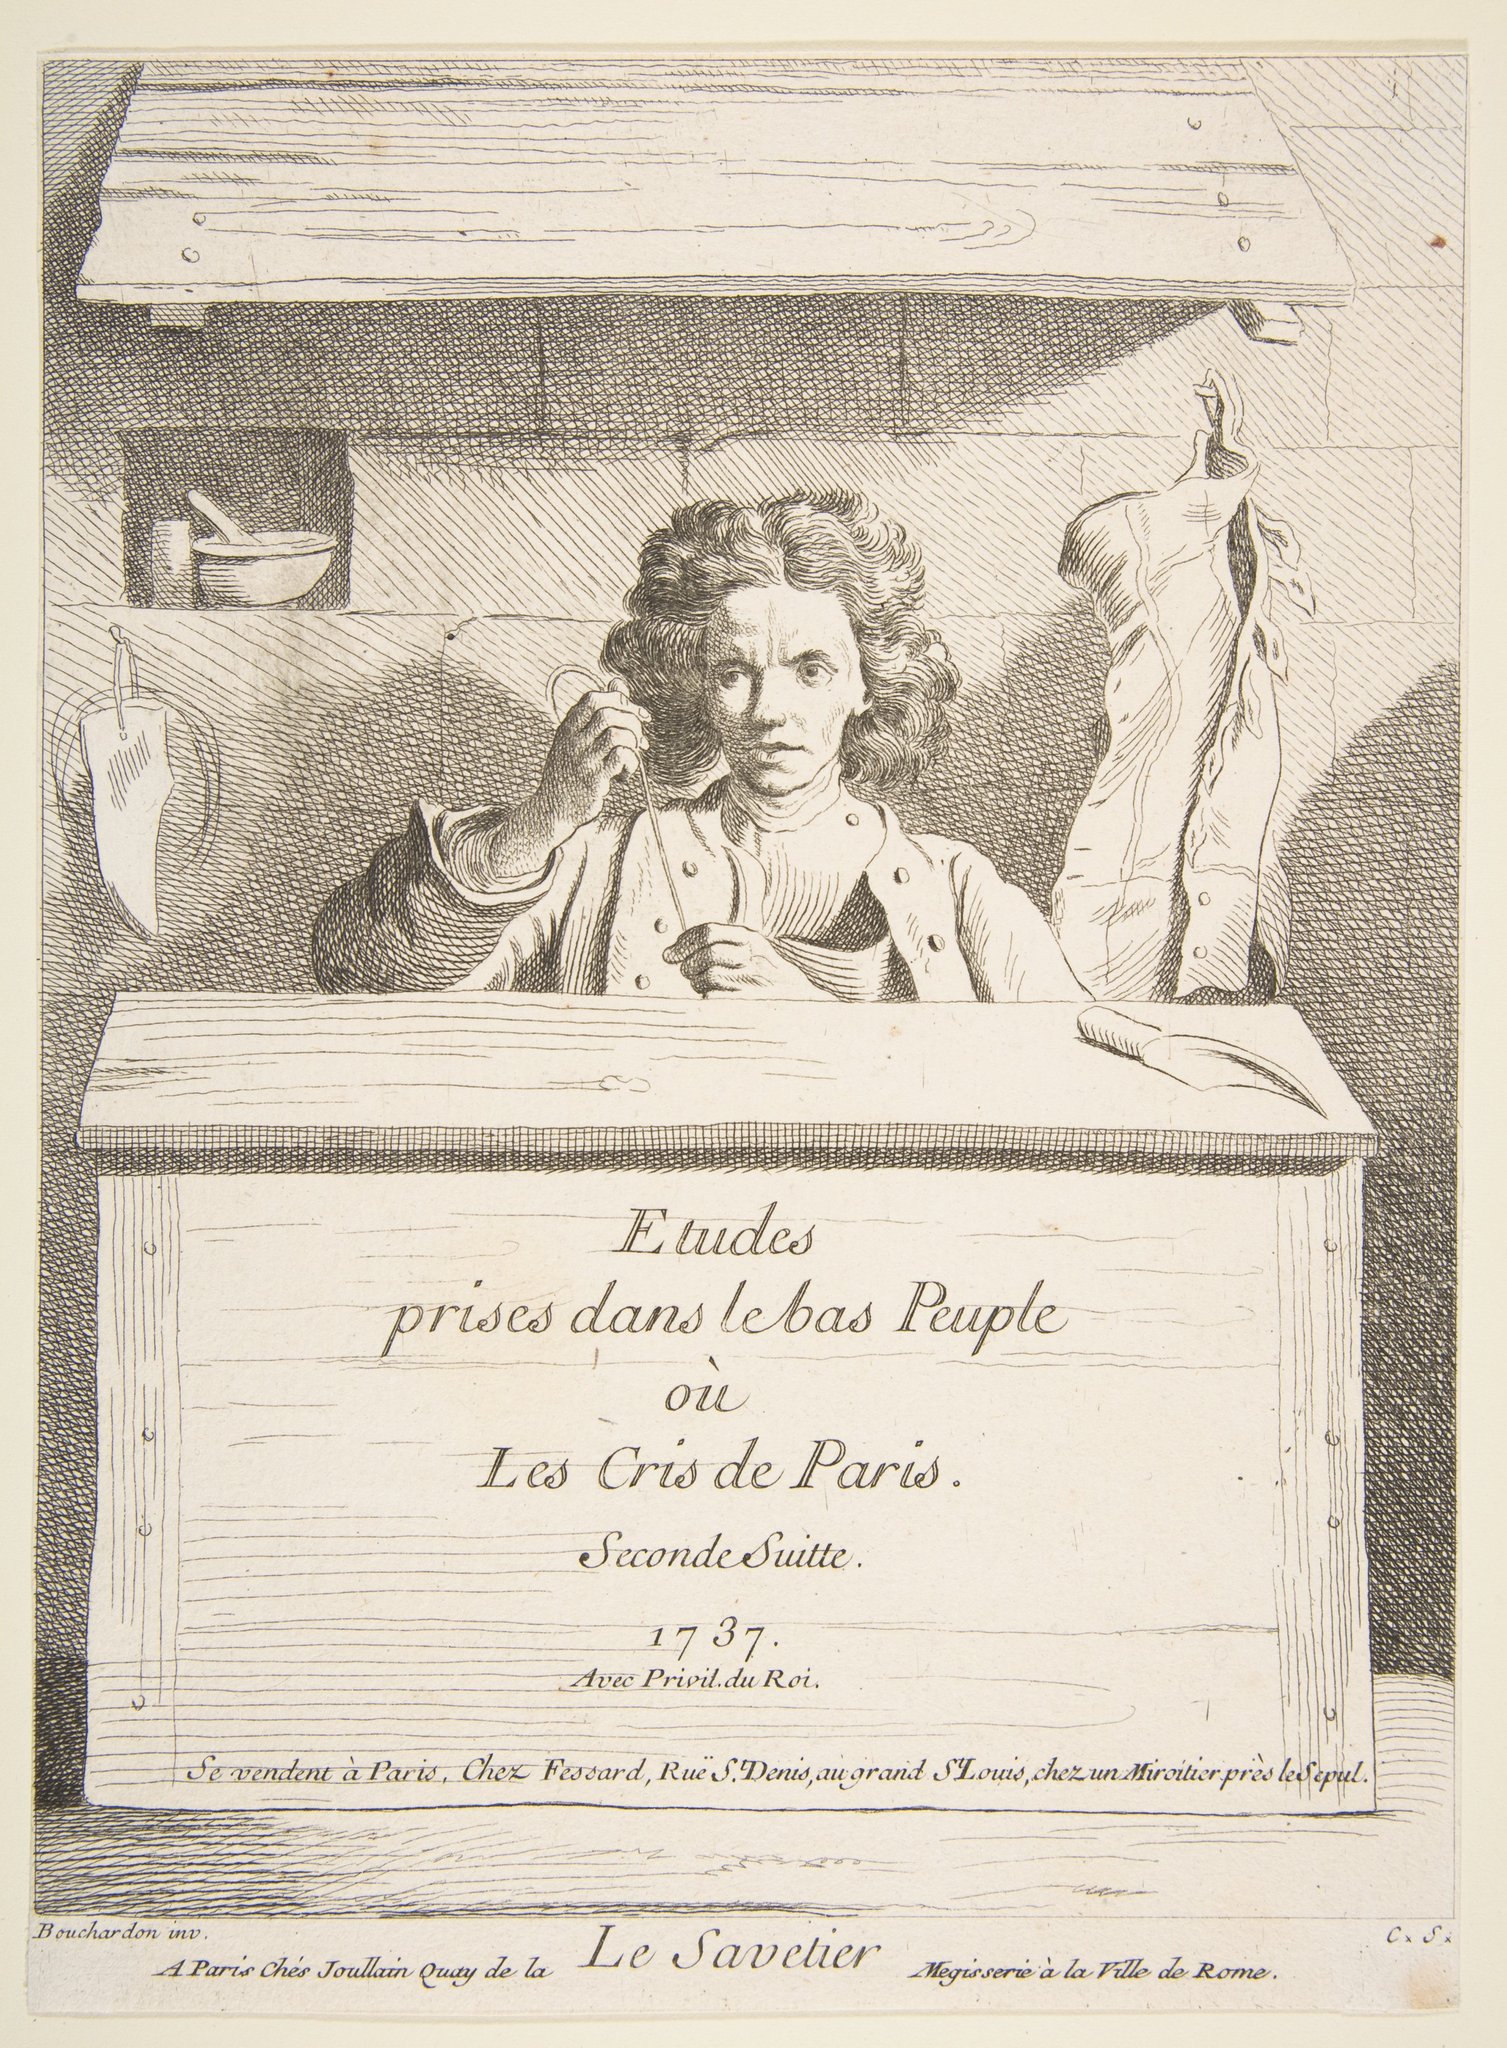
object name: print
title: The Cobbler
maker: edme bouchardon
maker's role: artist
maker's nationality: french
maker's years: 1698-1762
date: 1737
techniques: engraving, etching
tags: men